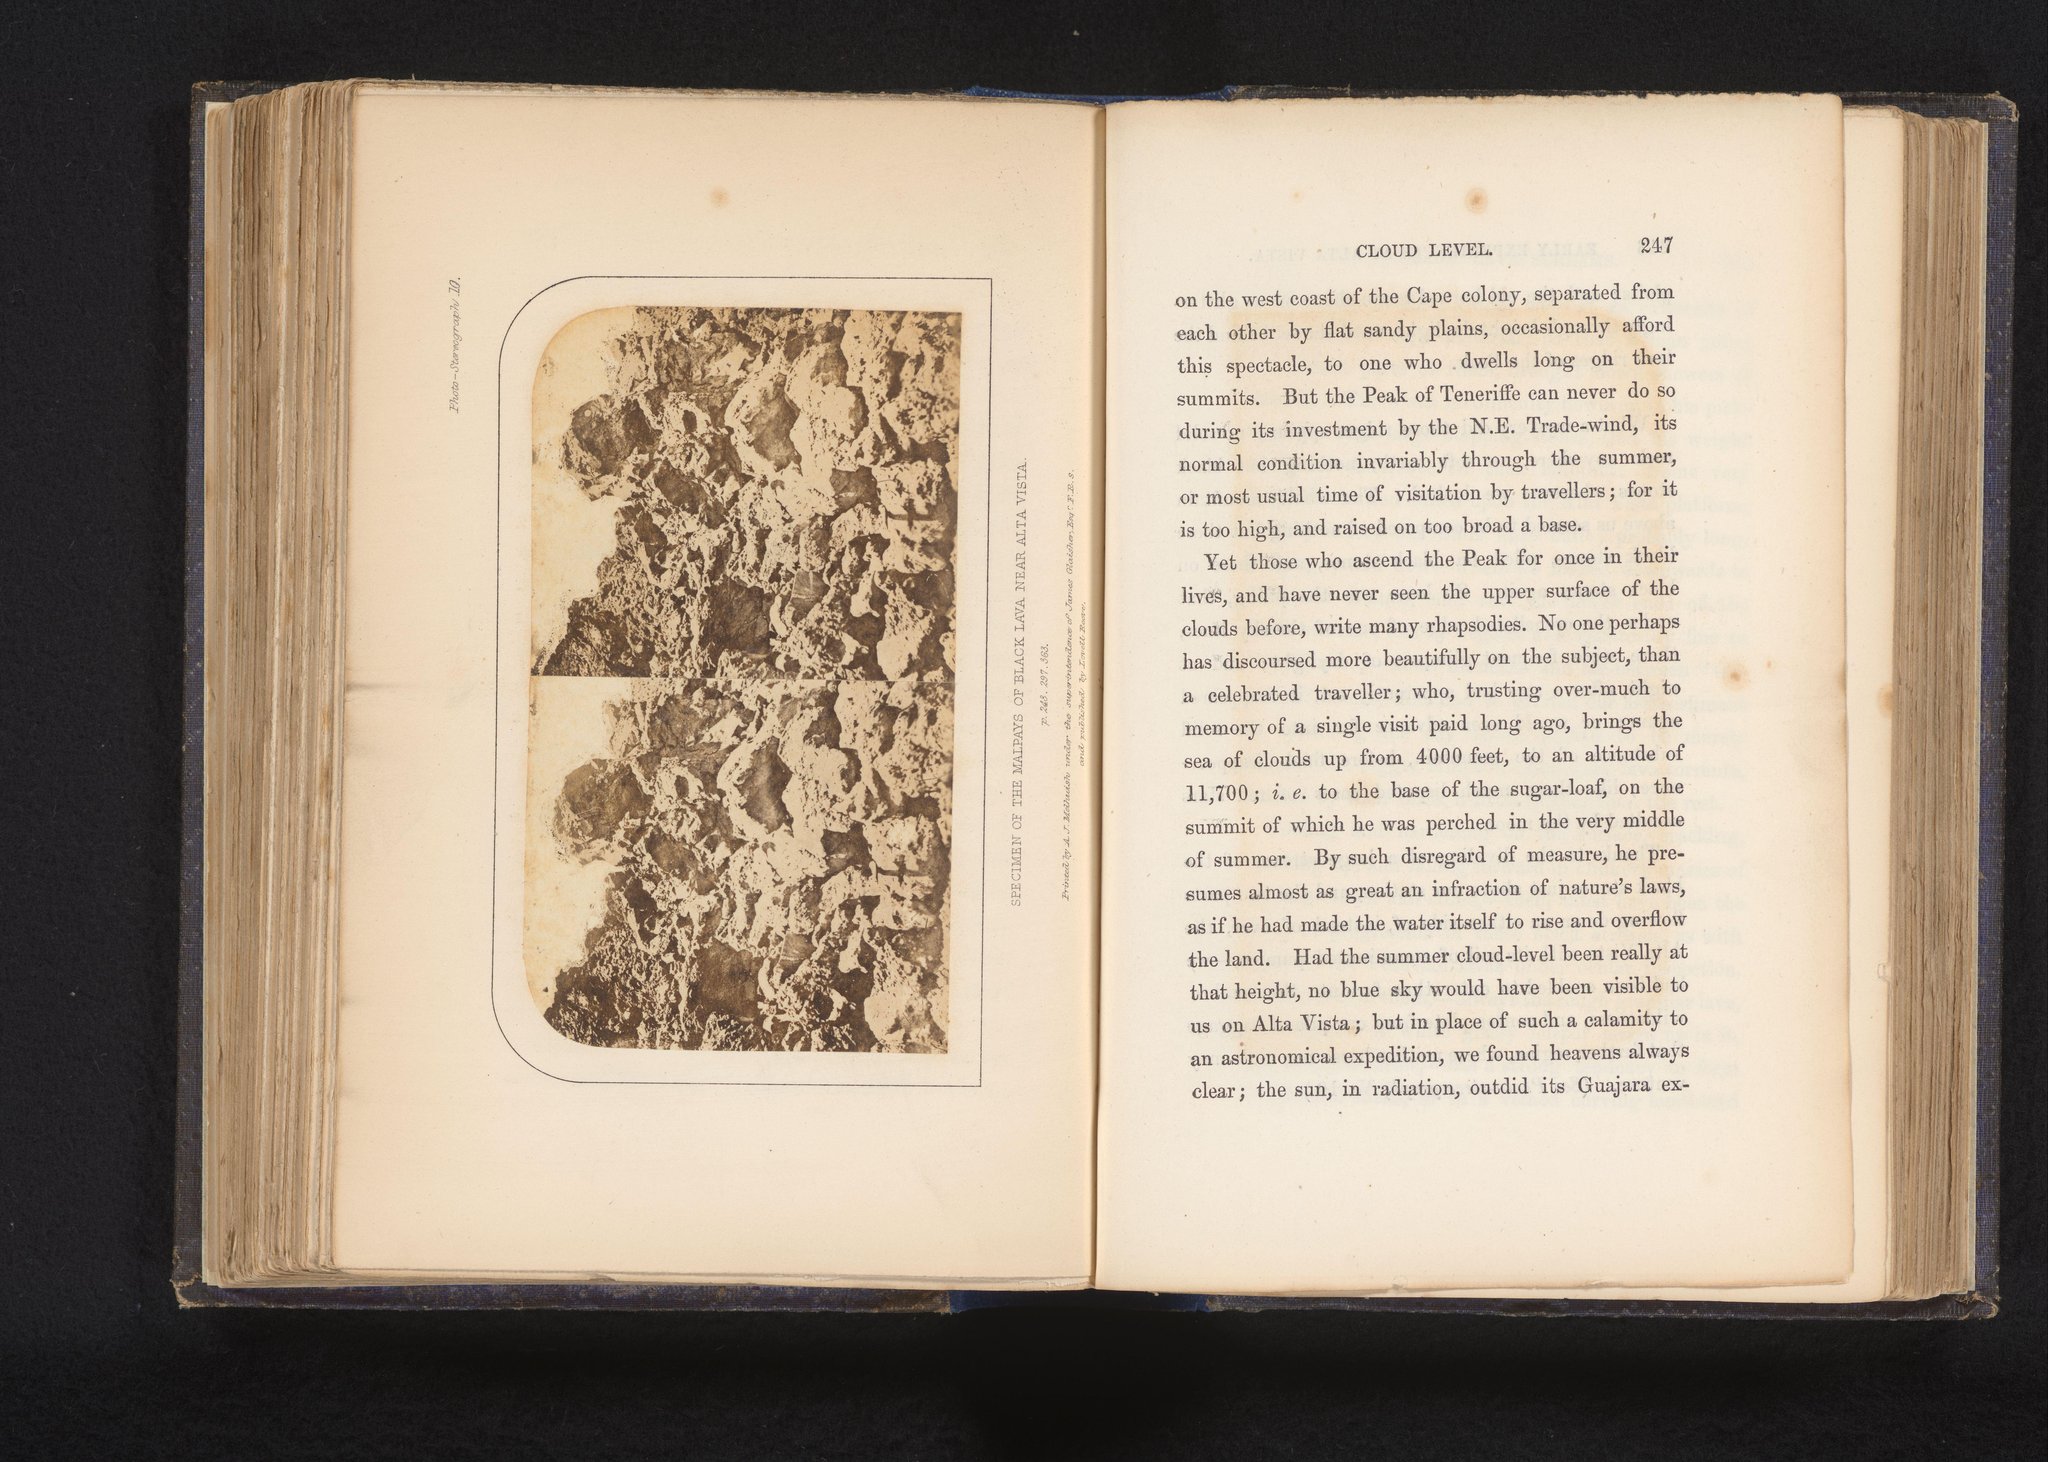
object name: stereograph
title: Specimen of the malpays of black lava near Alta Vista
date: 1856-1858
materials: paper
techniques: albumen print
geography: london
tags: cold lava, rock-formations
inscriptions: inscription: ‘Photo-Stereograph 10.’